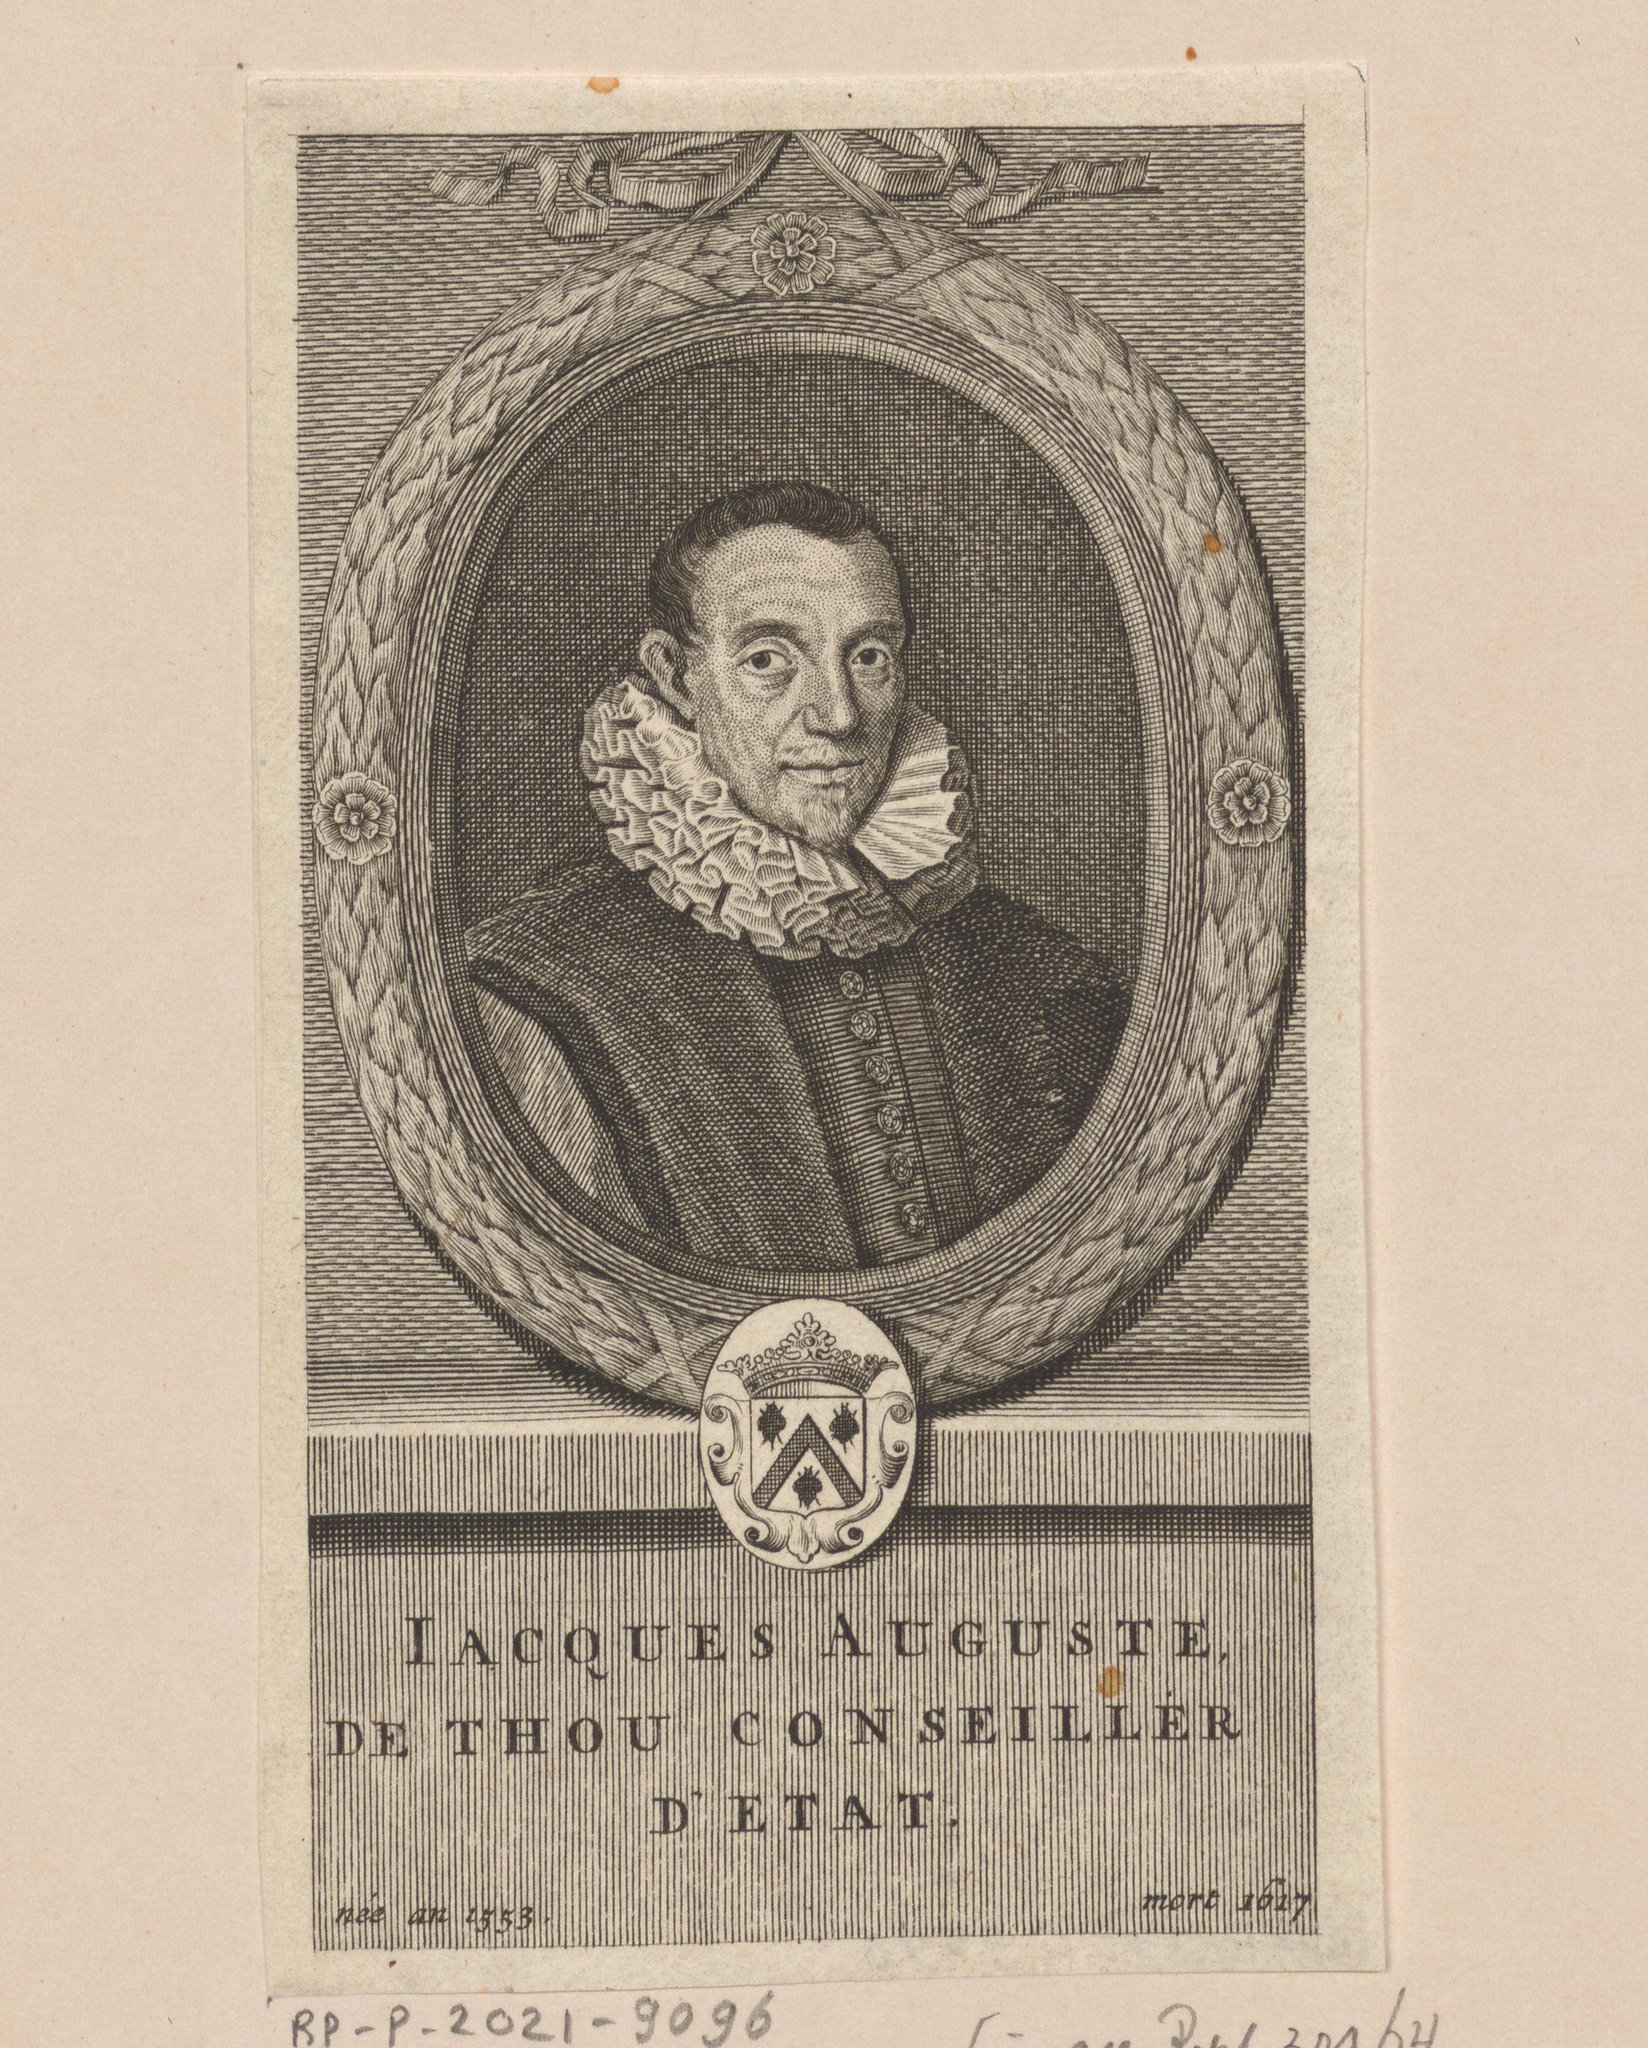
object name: book illustration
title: Portret van Jacques-Auguste de Thou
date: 1713-1714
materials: paper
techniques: engraving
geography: amsterdam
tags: historical persons, portrait of a writer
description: Prent gebruikt in: Thou, Jacques-Auguste de. Memoires de la vie de Jacques-Auguste de Thou. Amsterdam: François L'Honoré, 1713. Ook gebruikt in de 1714-editie. Mogelijk ook gebruikt in andere publicaties.